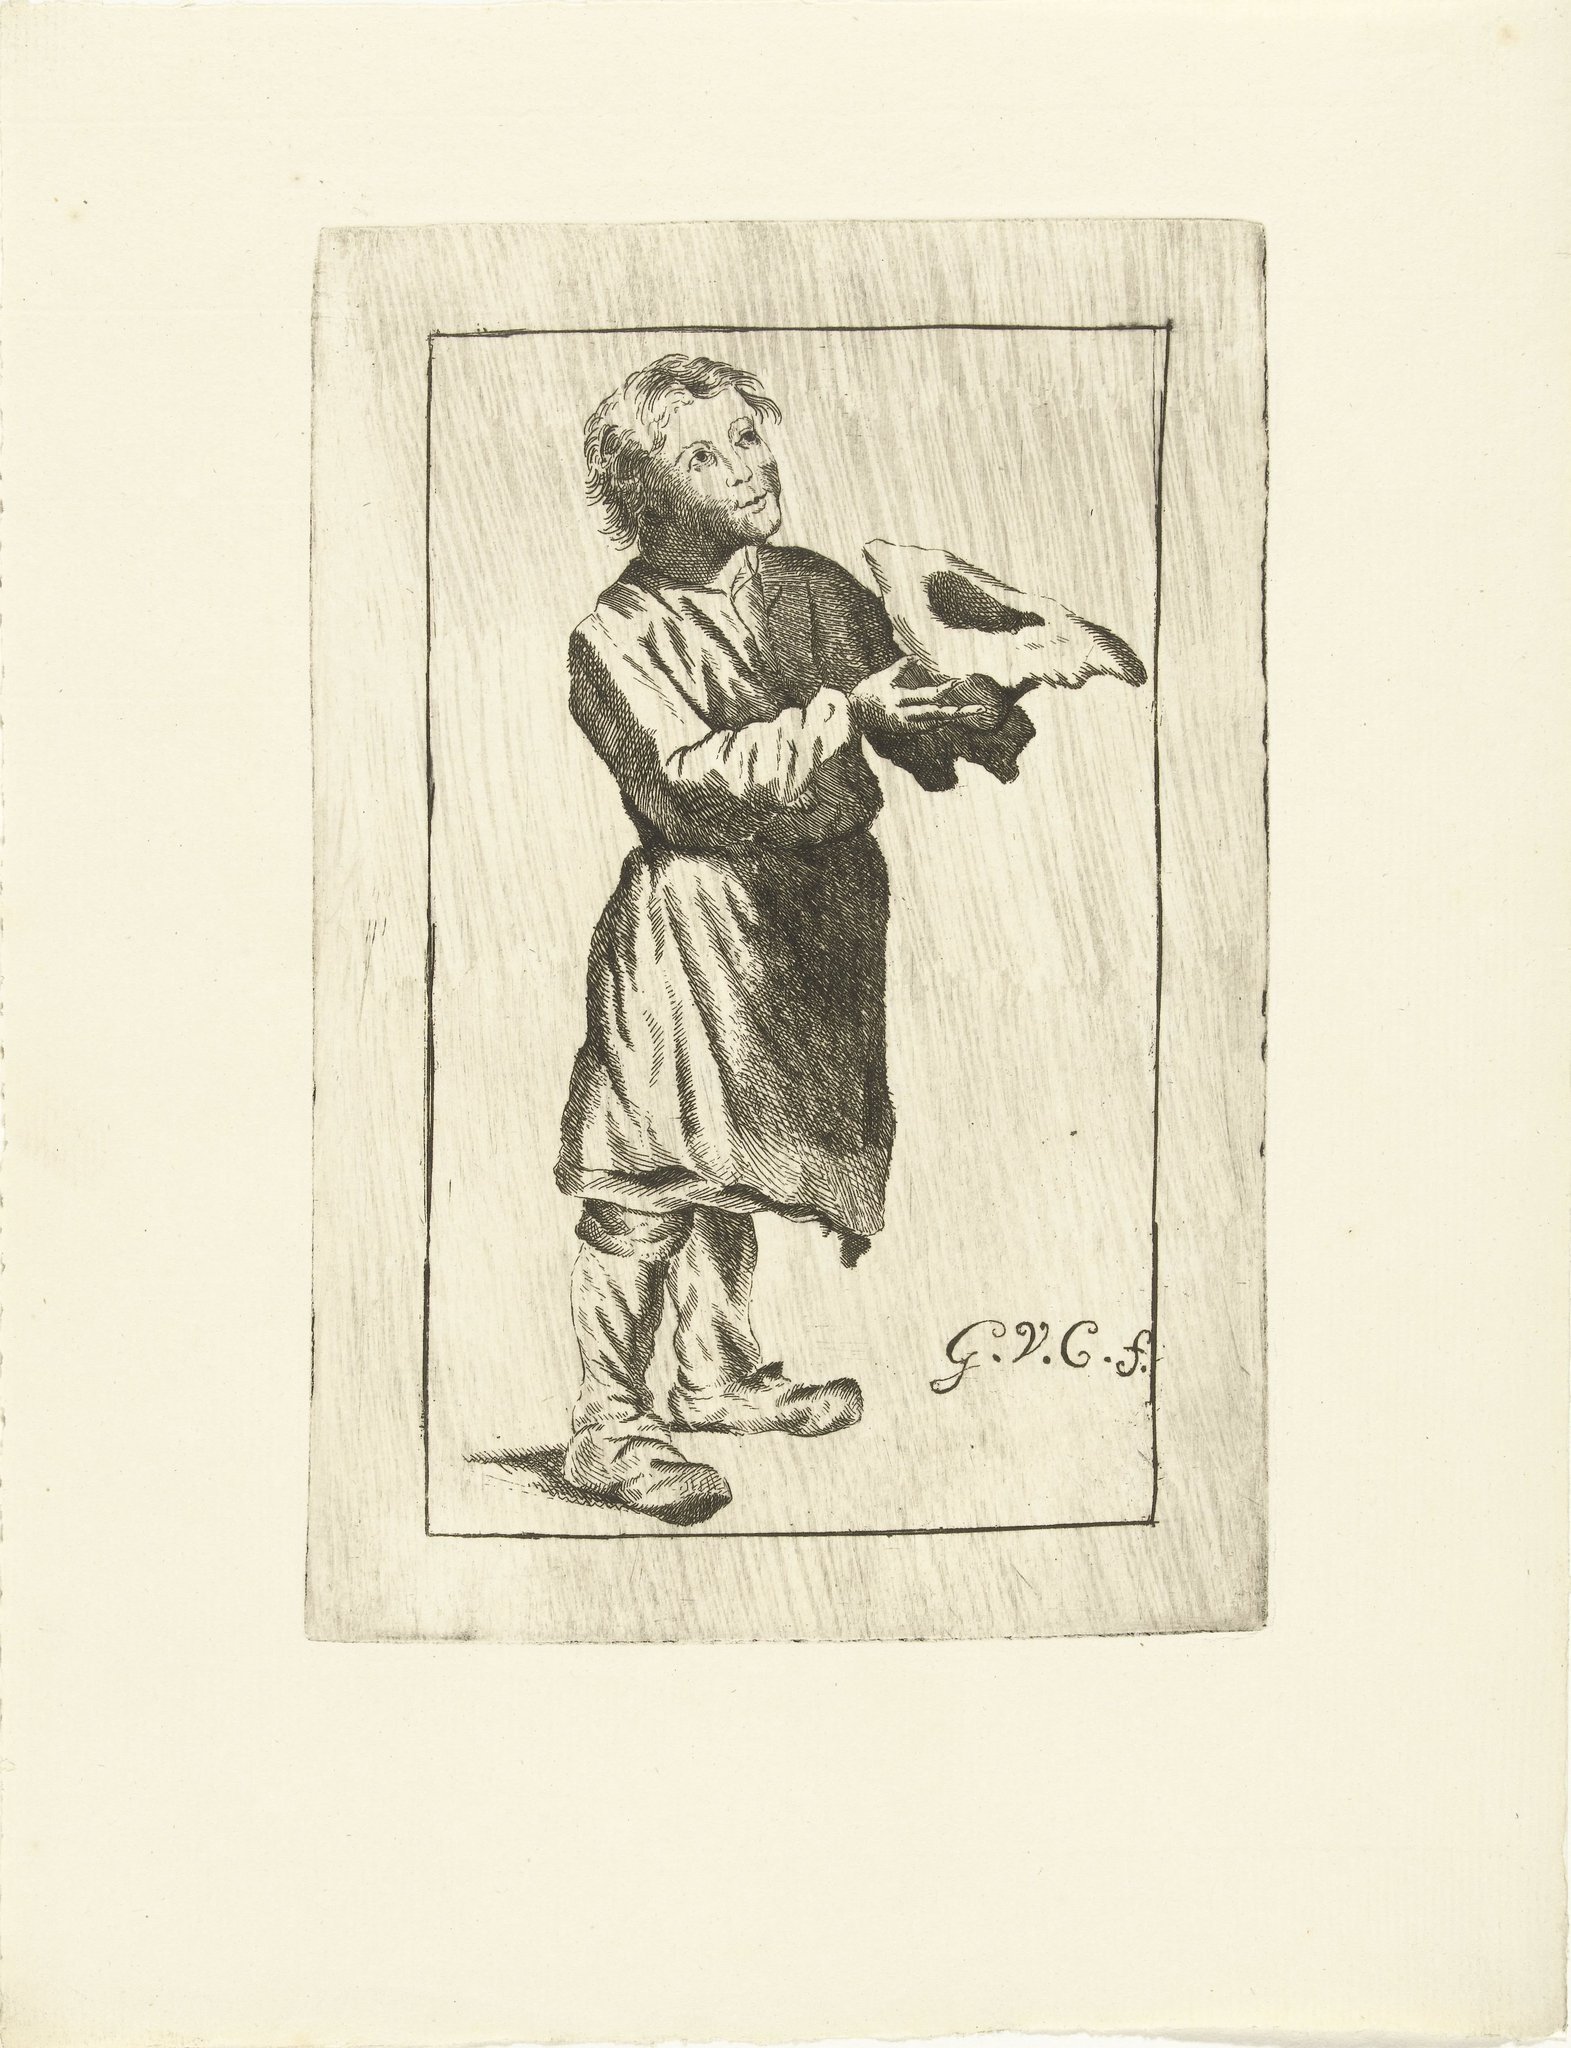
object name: print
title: Bedelaar met omgedraaide hoed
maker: g. van citters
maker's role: print maker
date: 1750-1800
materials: paper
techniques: etching, intaglio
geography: netherlands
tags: beggar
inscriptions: collector's mark: Lugt 2233